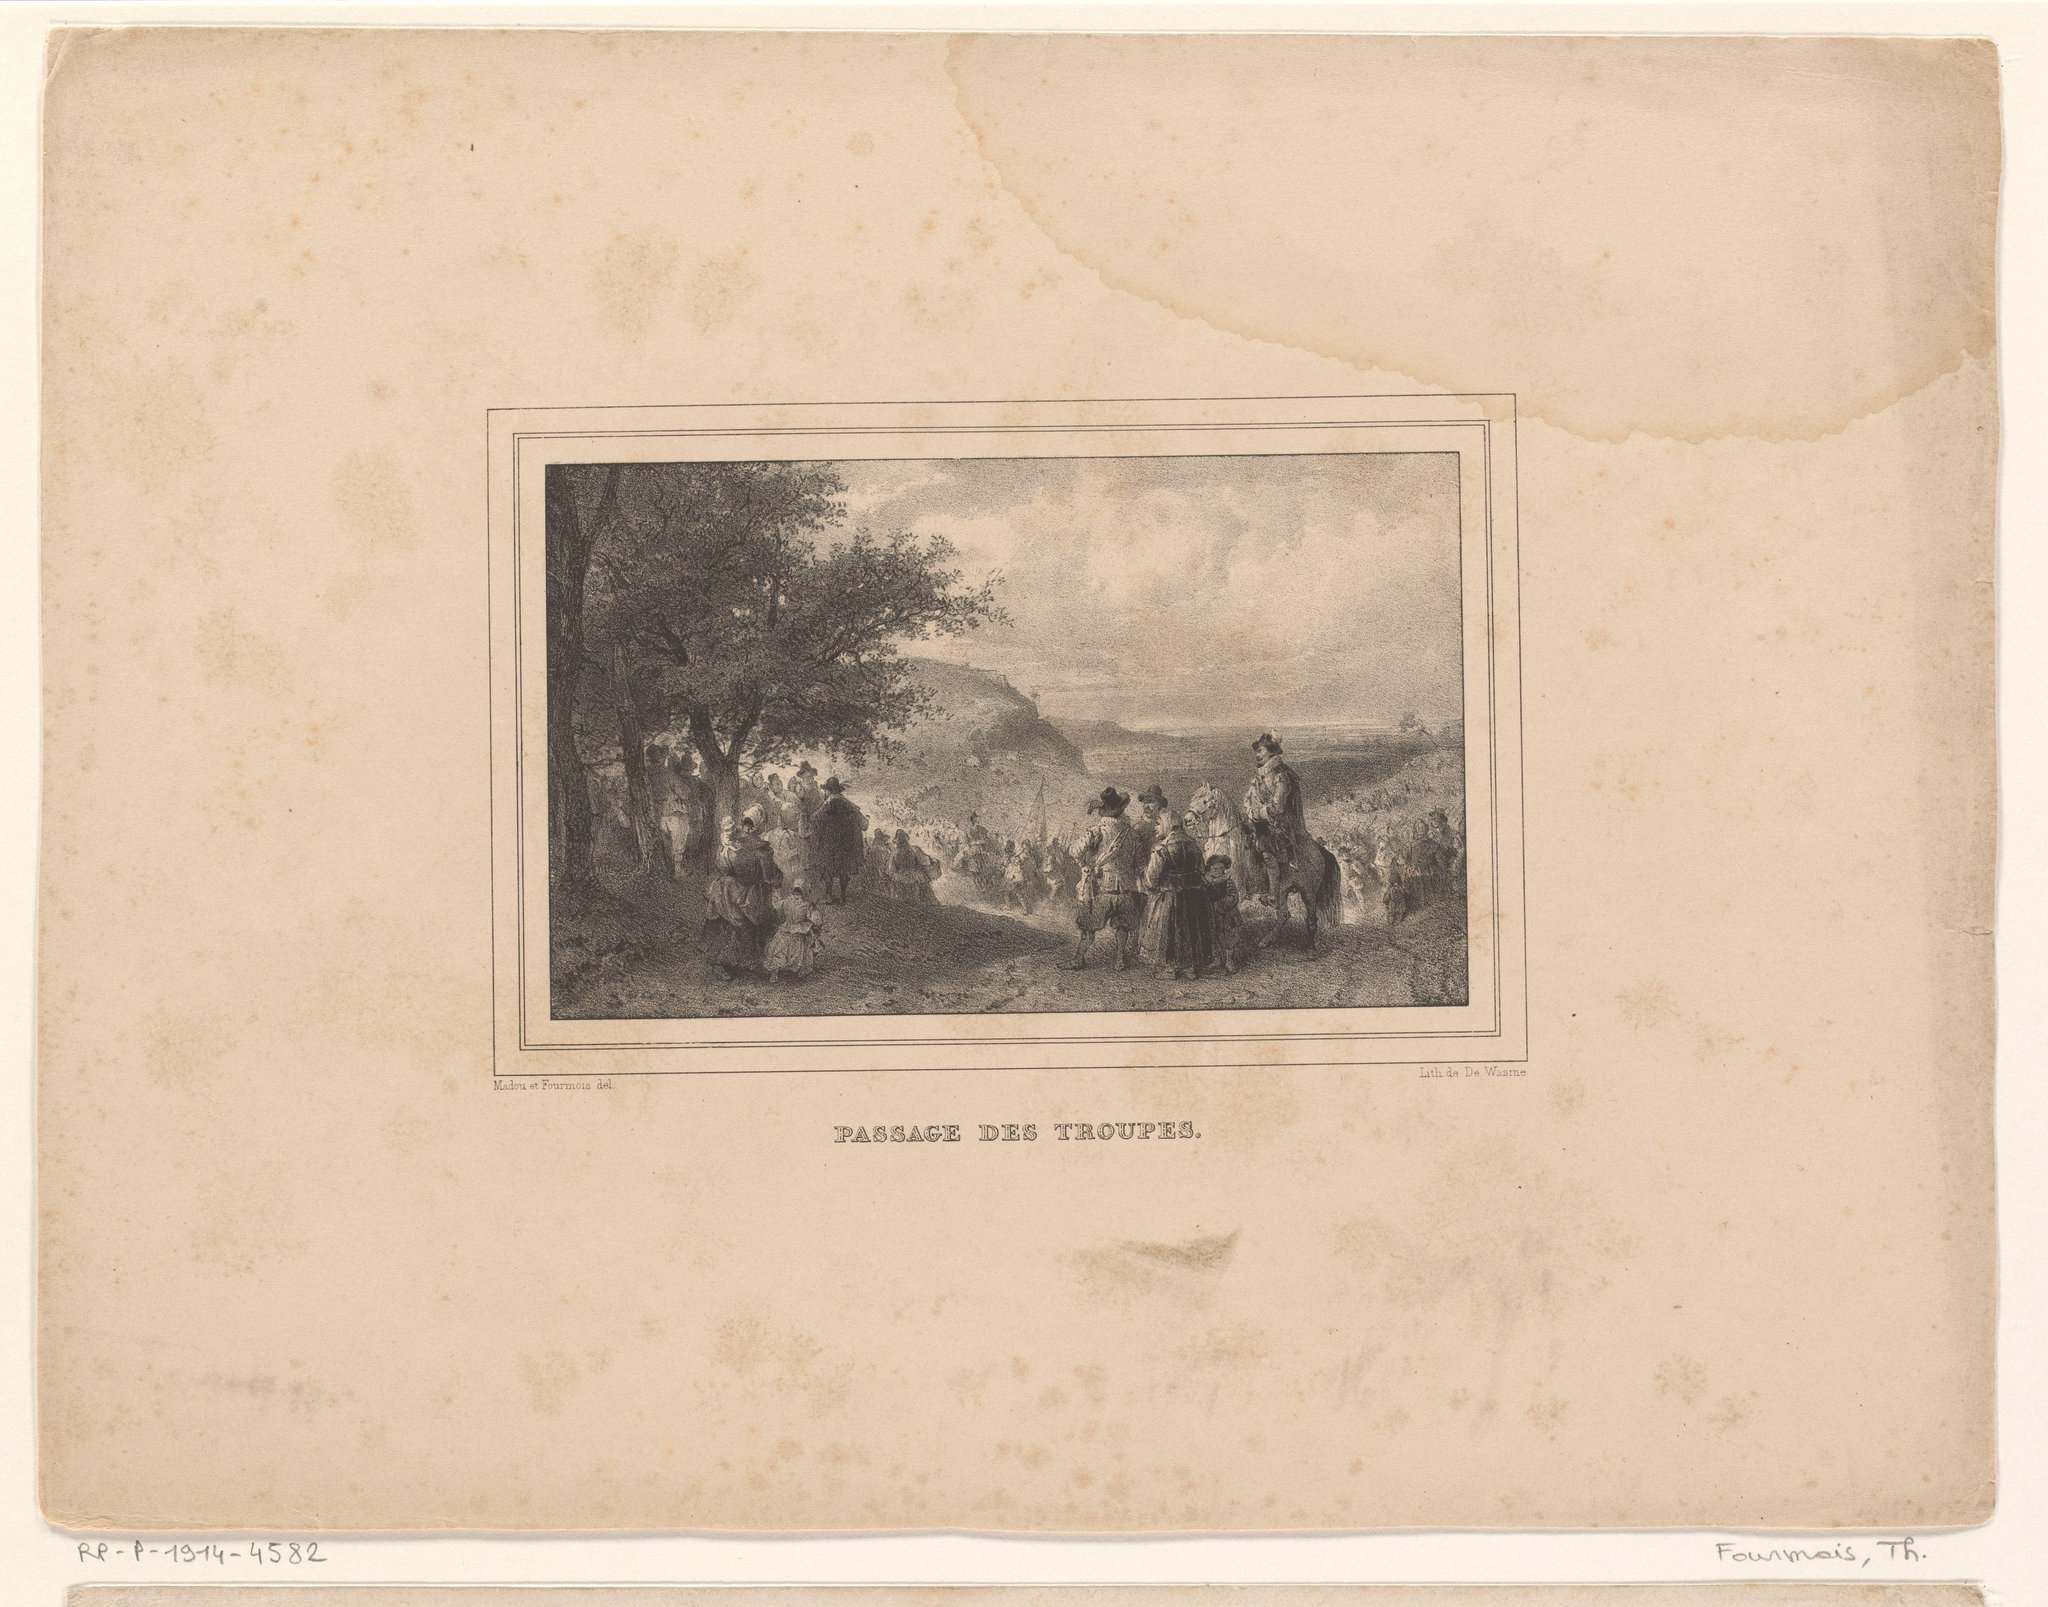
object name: print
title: Groep soldaten trekt door een heuvellandschap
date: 1834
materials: paper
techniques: lithograph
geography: brussels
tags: army 'en route', low hill country, the soldier; the soldier's life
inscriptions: collector's mark: Lugt 2228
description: Prent behoort tot een serie met twaalf genretaferelen vervaardigd door Madou en Fourmois. Vier prenten zijn enkel door Madou vervaardigd en de overige prenten door Madou en Fourmois samen. Madou vervaardigde de figuren en Fourmois het landschap.